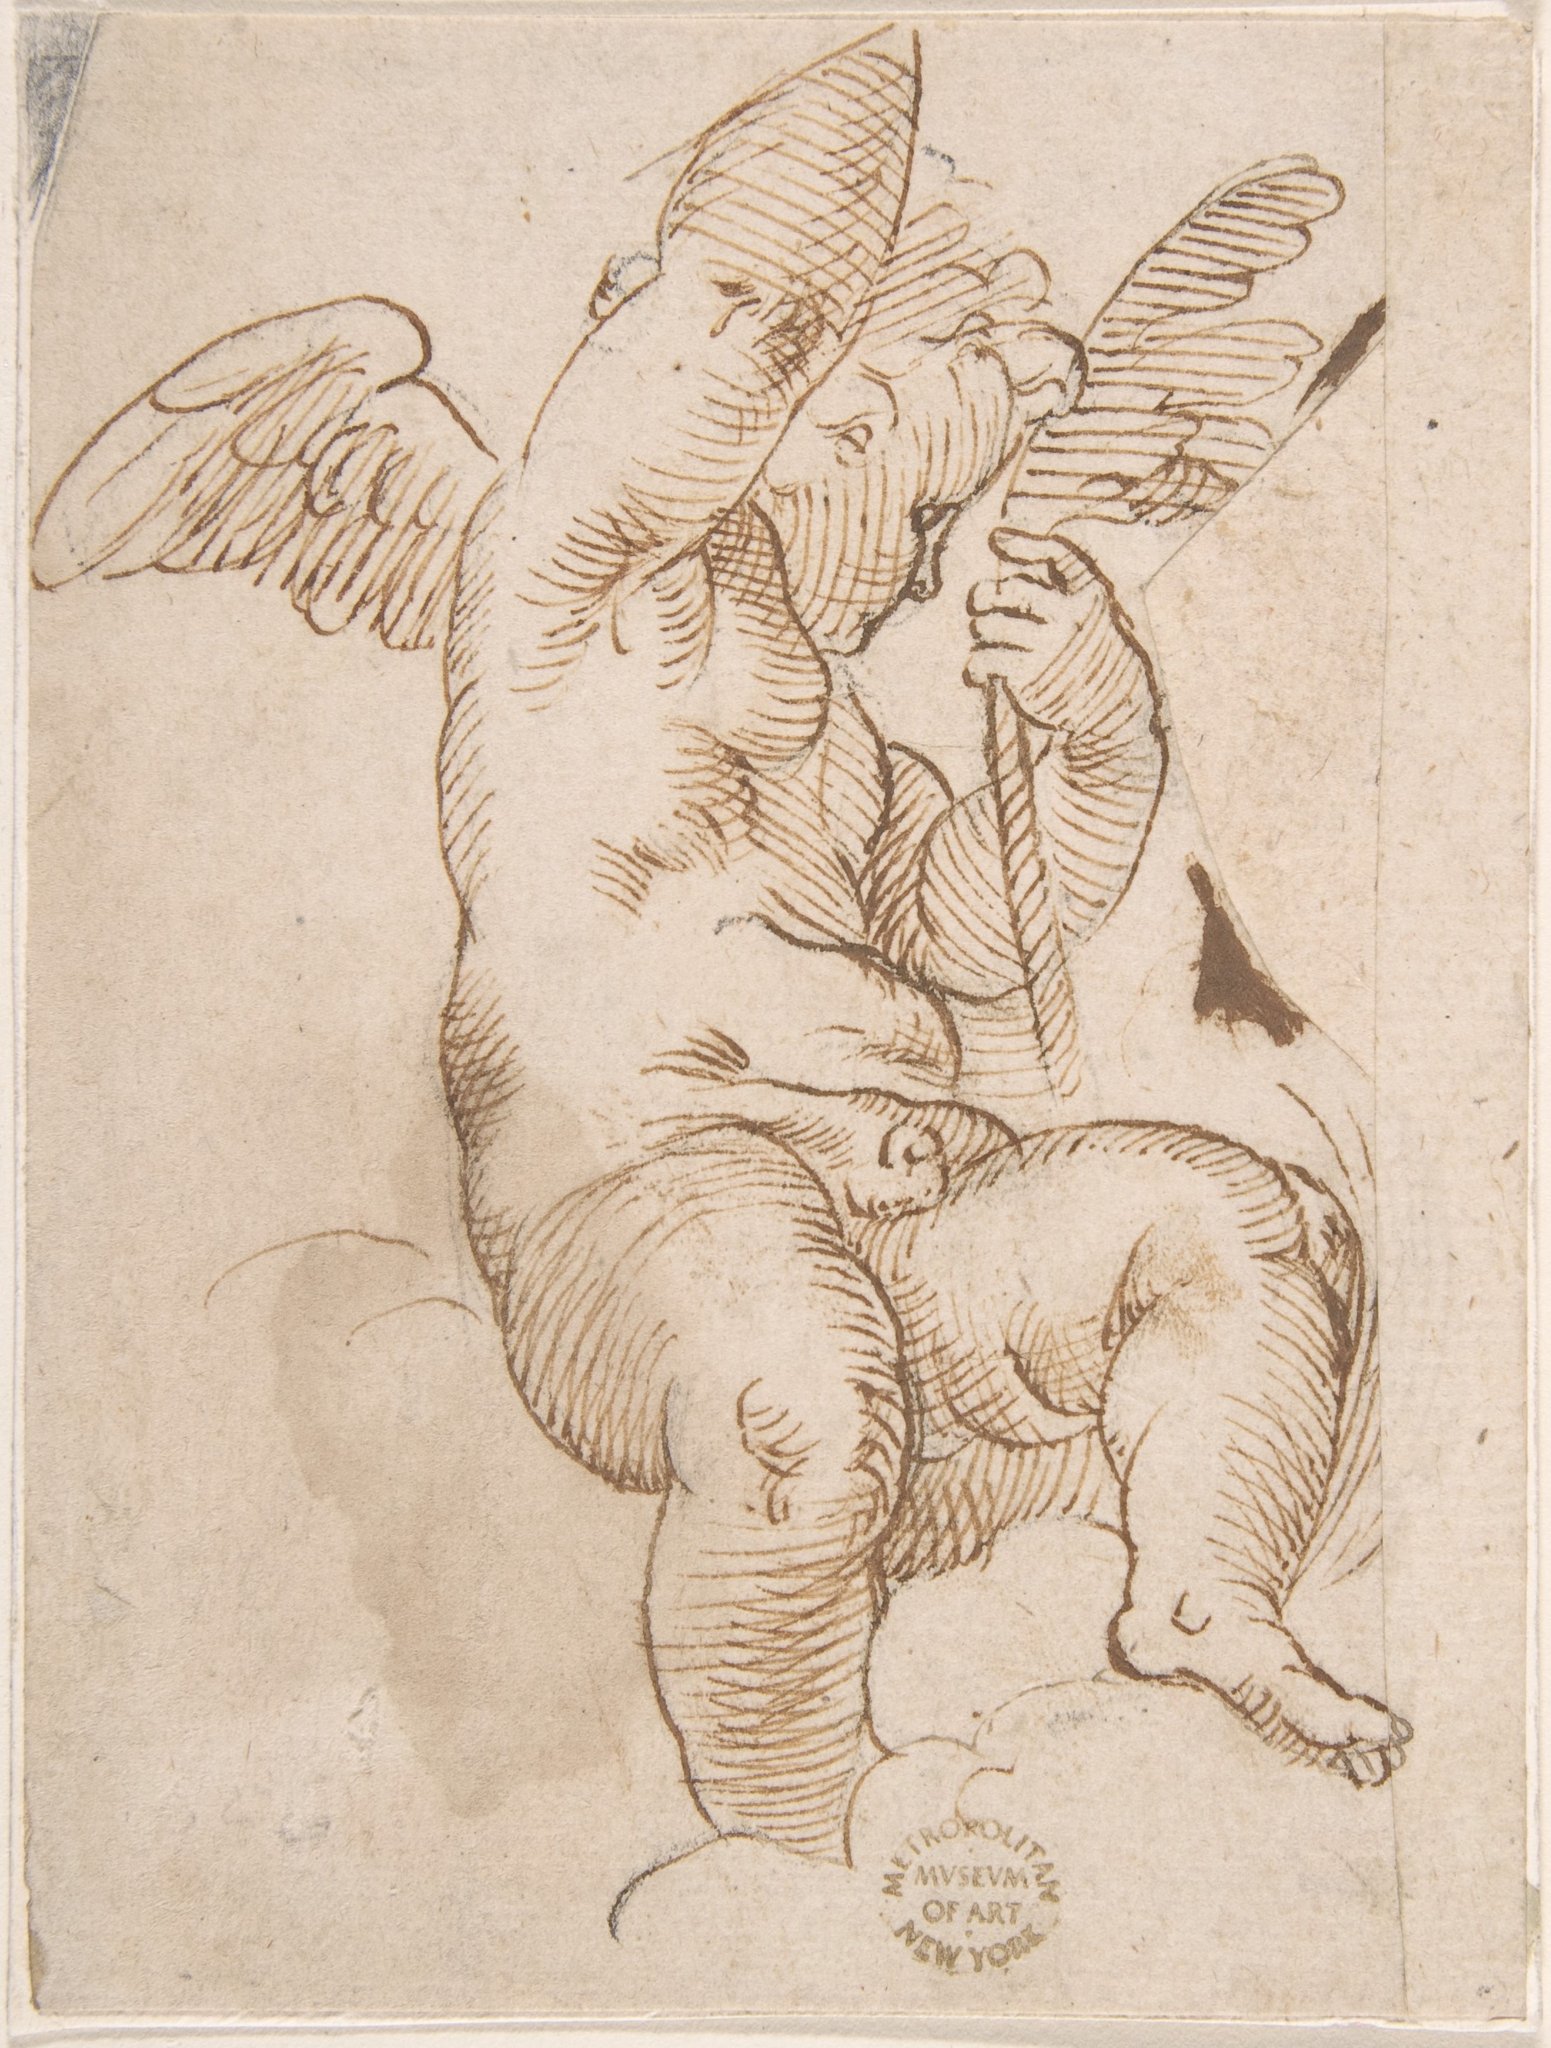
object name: drawing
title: Cupid Seated on a Cloud and Holding a Palm (?)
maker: anonymous, italian, emilian, mid-16th century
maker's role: artist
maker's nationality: italian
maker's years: 1530-1580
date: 1501-1600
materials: ink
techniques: pen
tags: cupid